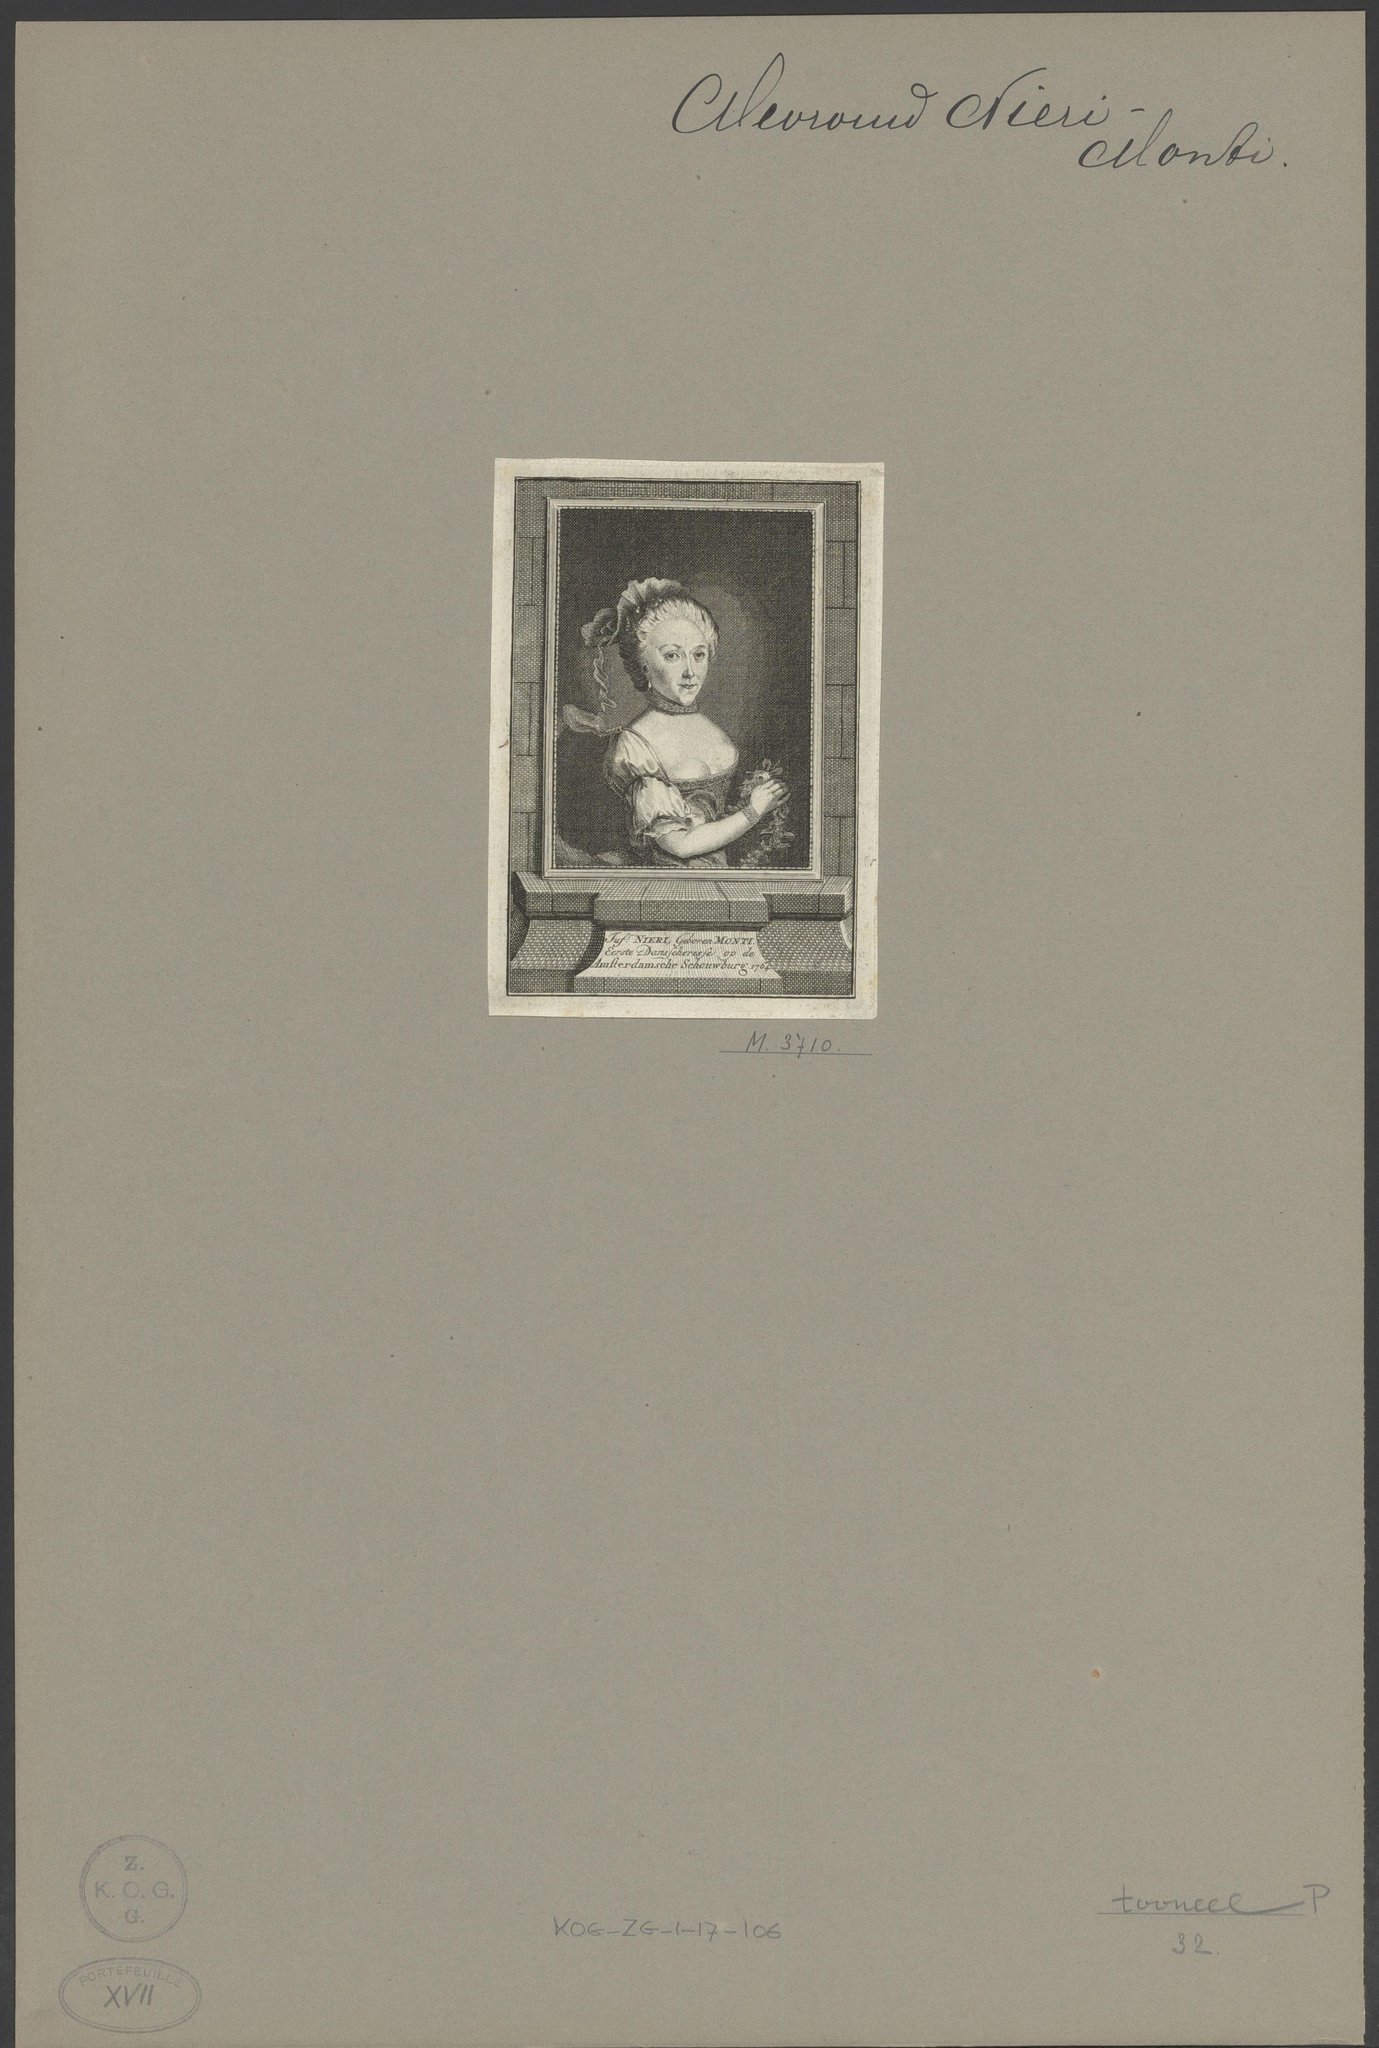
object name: print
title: Portret van Gomana Girolama Monti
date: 1764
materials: paper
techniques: engraving, etching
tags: historical persons - bb - woman, female dancer, portrait of dancer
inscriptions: stamp, collector's mark: Lugt 1641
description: Portret van Gomana Girolama Monti, later Nieri. Danste als eerste danseres bij de Amsterdamse Schouwburg. Onderwerpsrubrieken binnen de Atlas Zeden en Gewoonten: Tooneel, Portretten van toneelspelers.